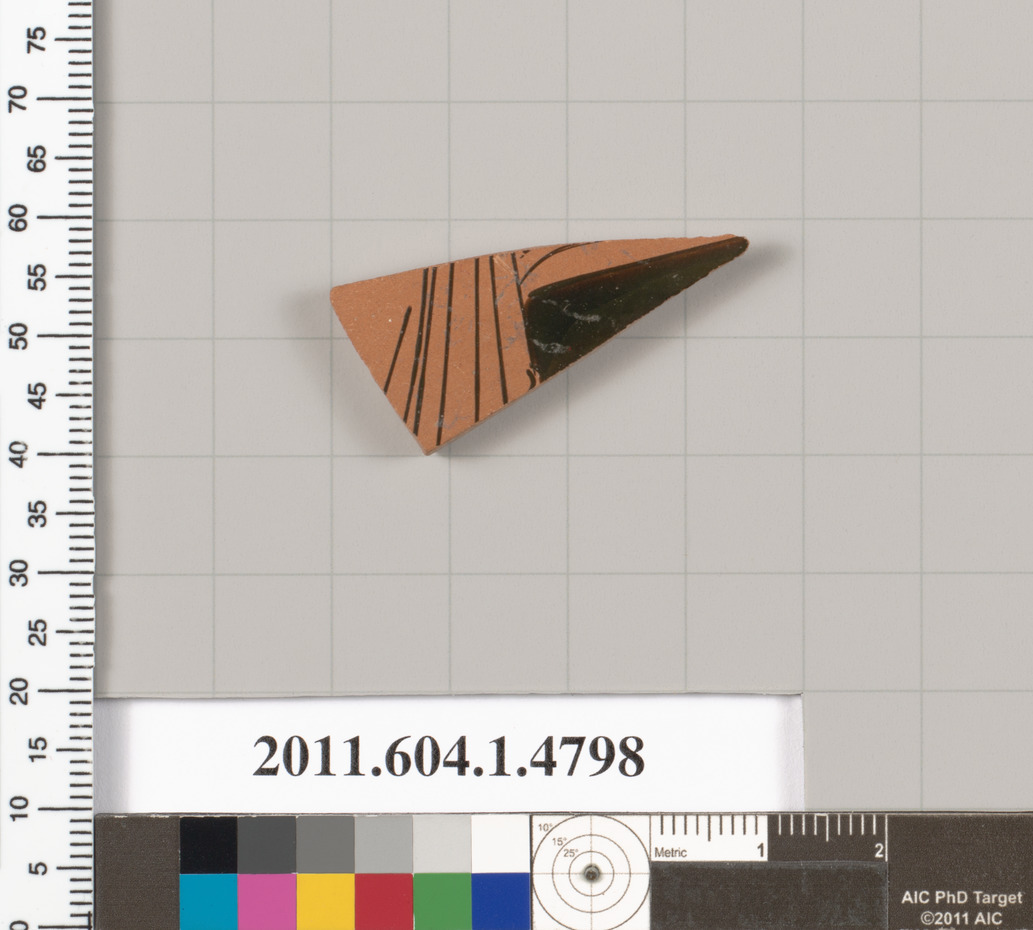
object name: kylix fragment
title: Terracotta fragment of a kylix (drinking cup)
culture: greek, attic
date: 475-451 BCE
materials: terracotta